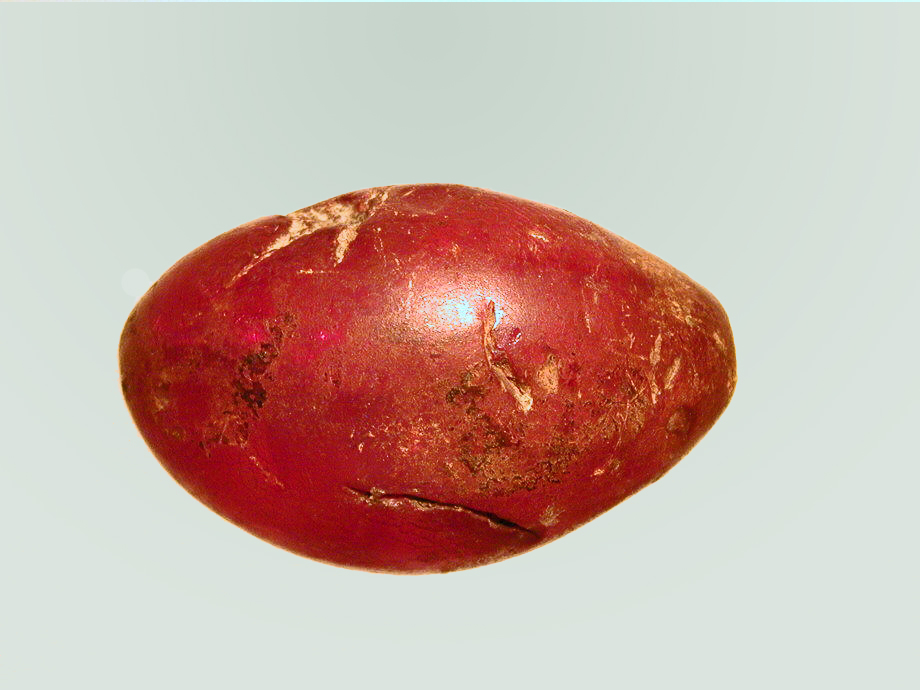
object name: fibula, amber from bow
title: Amber from bow of a bronze fibula (safety pin)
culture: etruscan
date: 700-501 BCE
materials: amber